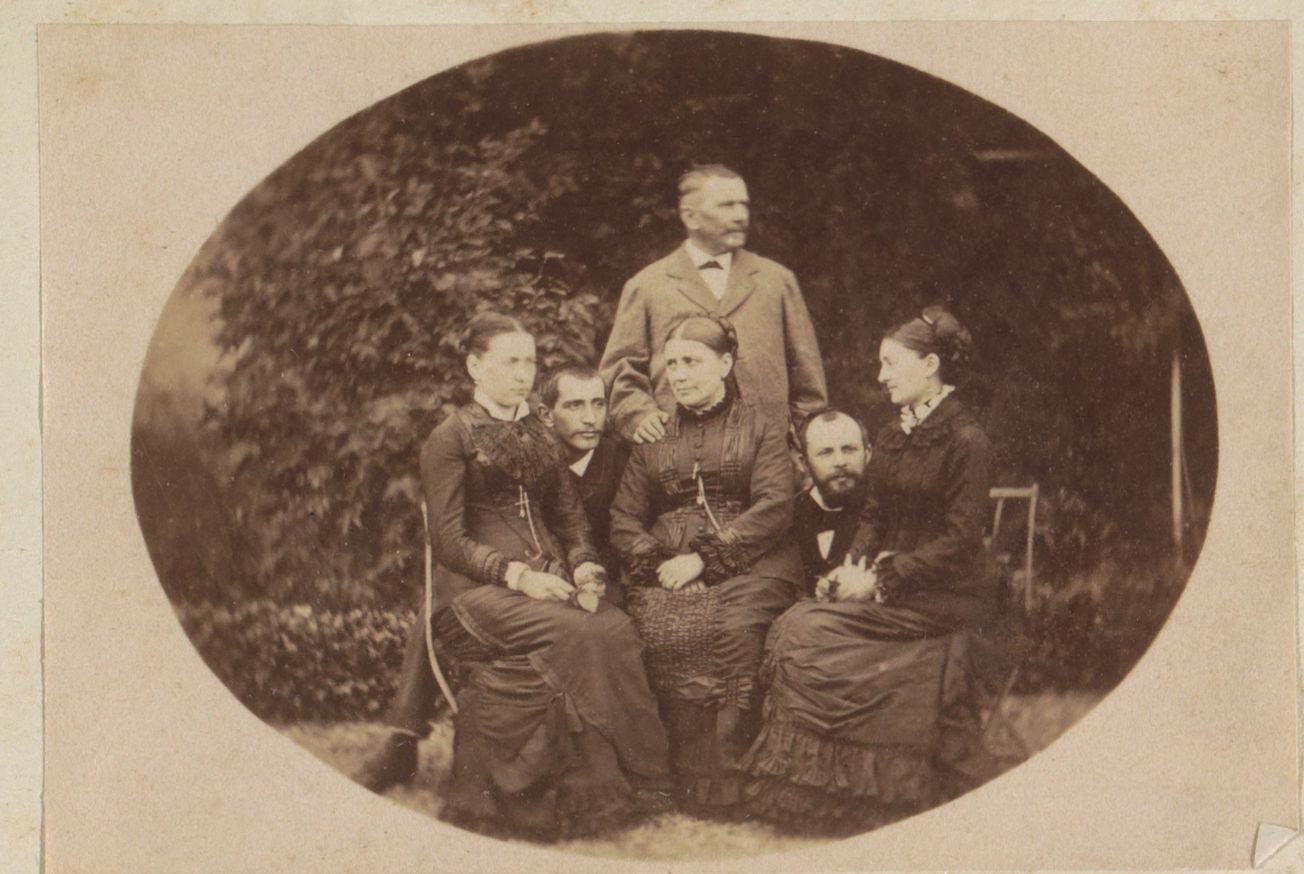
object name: photograph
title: Groepsportret van drie Fransen en drie Françaises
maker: Anonymous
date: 1883-1886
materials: photographic support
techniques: albumen print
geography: france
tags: brothers or sisters (second degree family relationships)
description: Onderdeel van Album van een Franse amateurfotograaf met opnames van familie, militairen, industrie, landschappen en bezienswaardigheden in Frankrijk.